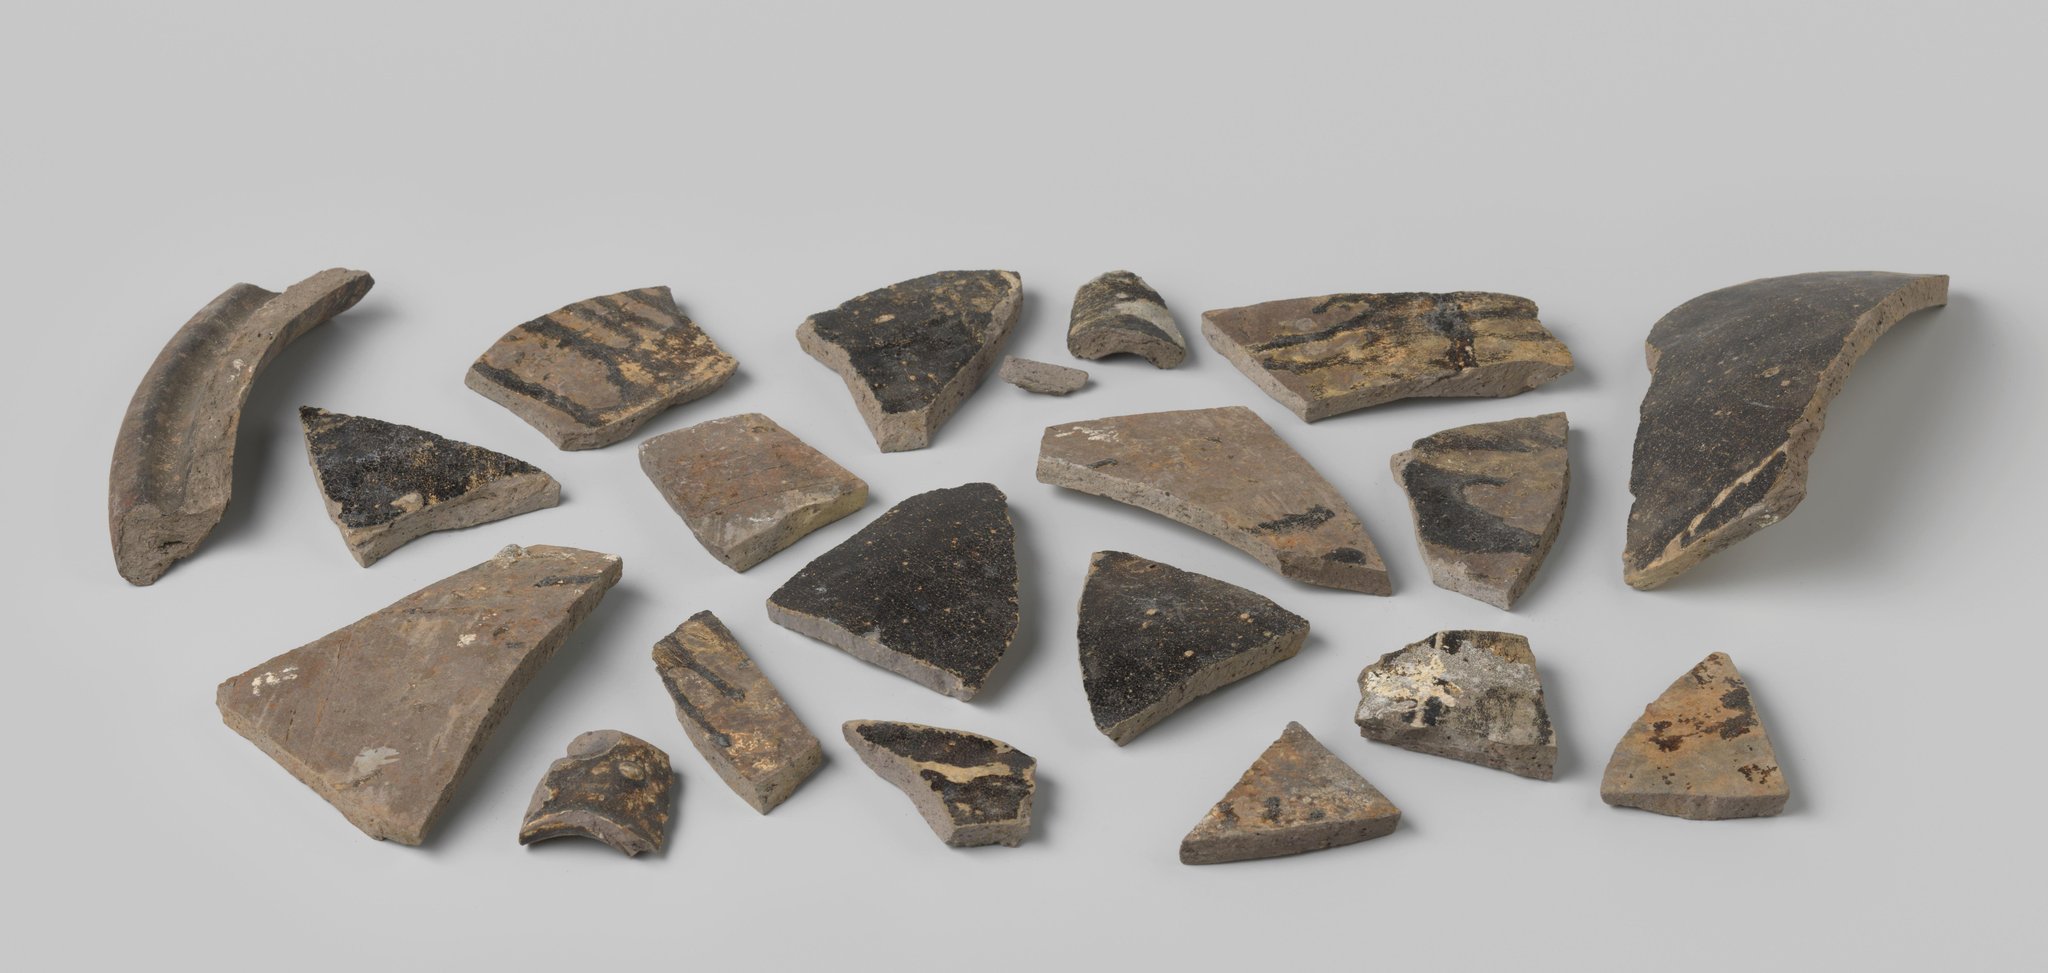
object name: sherd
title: Scherven van martavanen uit V.O.C.-schip de 'Witte Leeuw'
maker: Anonymous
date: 1613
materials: porcelain, stoneware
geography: martaban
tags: verenigde oostindische compagnie, sint-helena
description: A jar. On the interior, only the lip is glazed. Beneath neck and shoulder is a band with underneath a dotted line. Bands of slip run down from the height of the ears till one-third of the lower part. The ears are decorated with dots made of the same type of clay as the body. The jar has been made in two parts: the upper half is larger than the lower half. A similar jar was found in the wreck of the San Antonio da Tanna sunk in 1697.